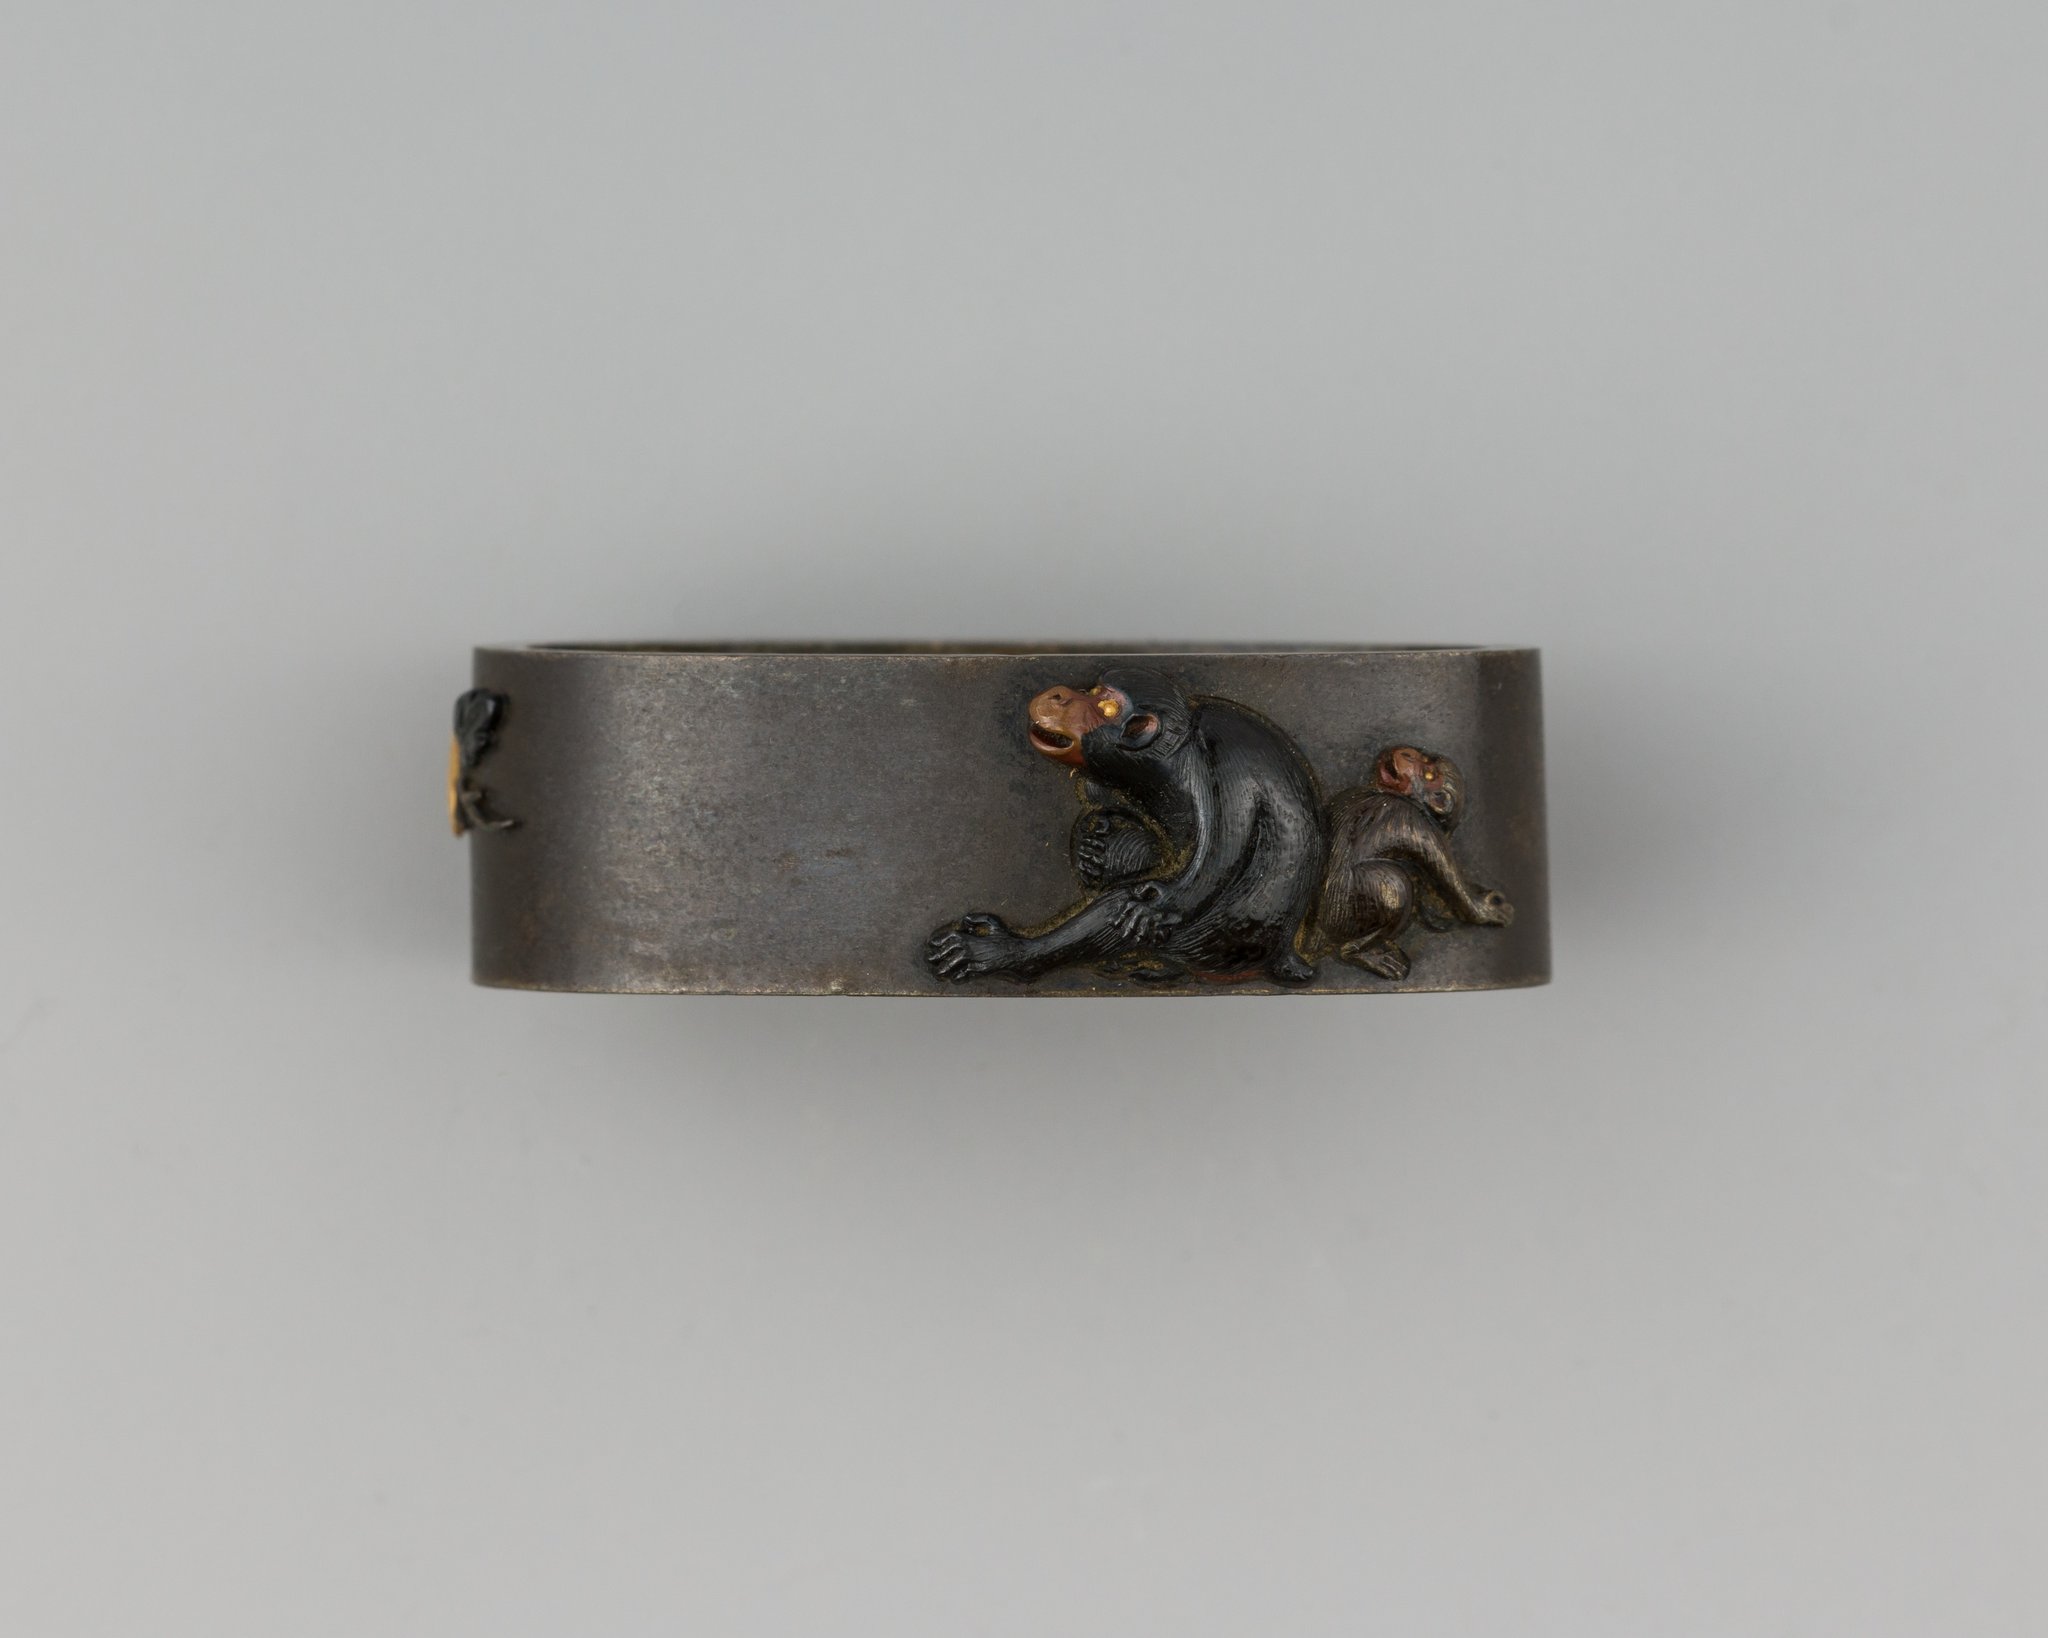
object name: sword hilt collar fuchi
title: Sword-Hilt Collar (Fuchi)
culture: japanese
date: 1615-1868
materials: copper, gold alloy, silver alloy, gold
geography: japan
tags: monkeys